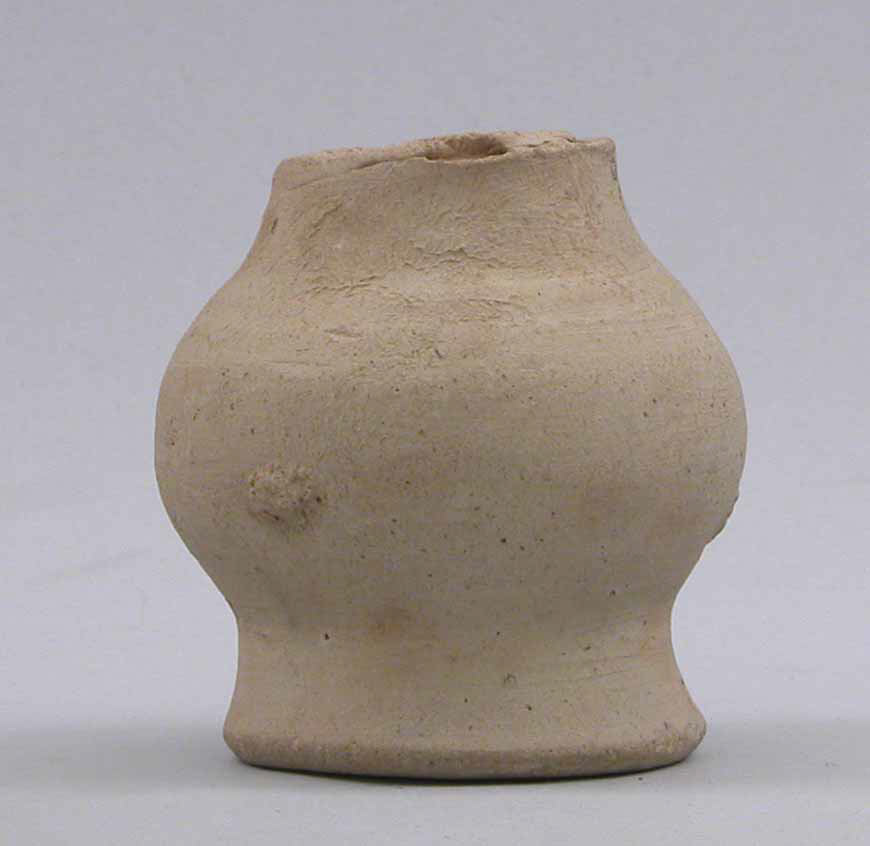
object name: jar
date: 701-1000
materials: earthenware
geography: iran